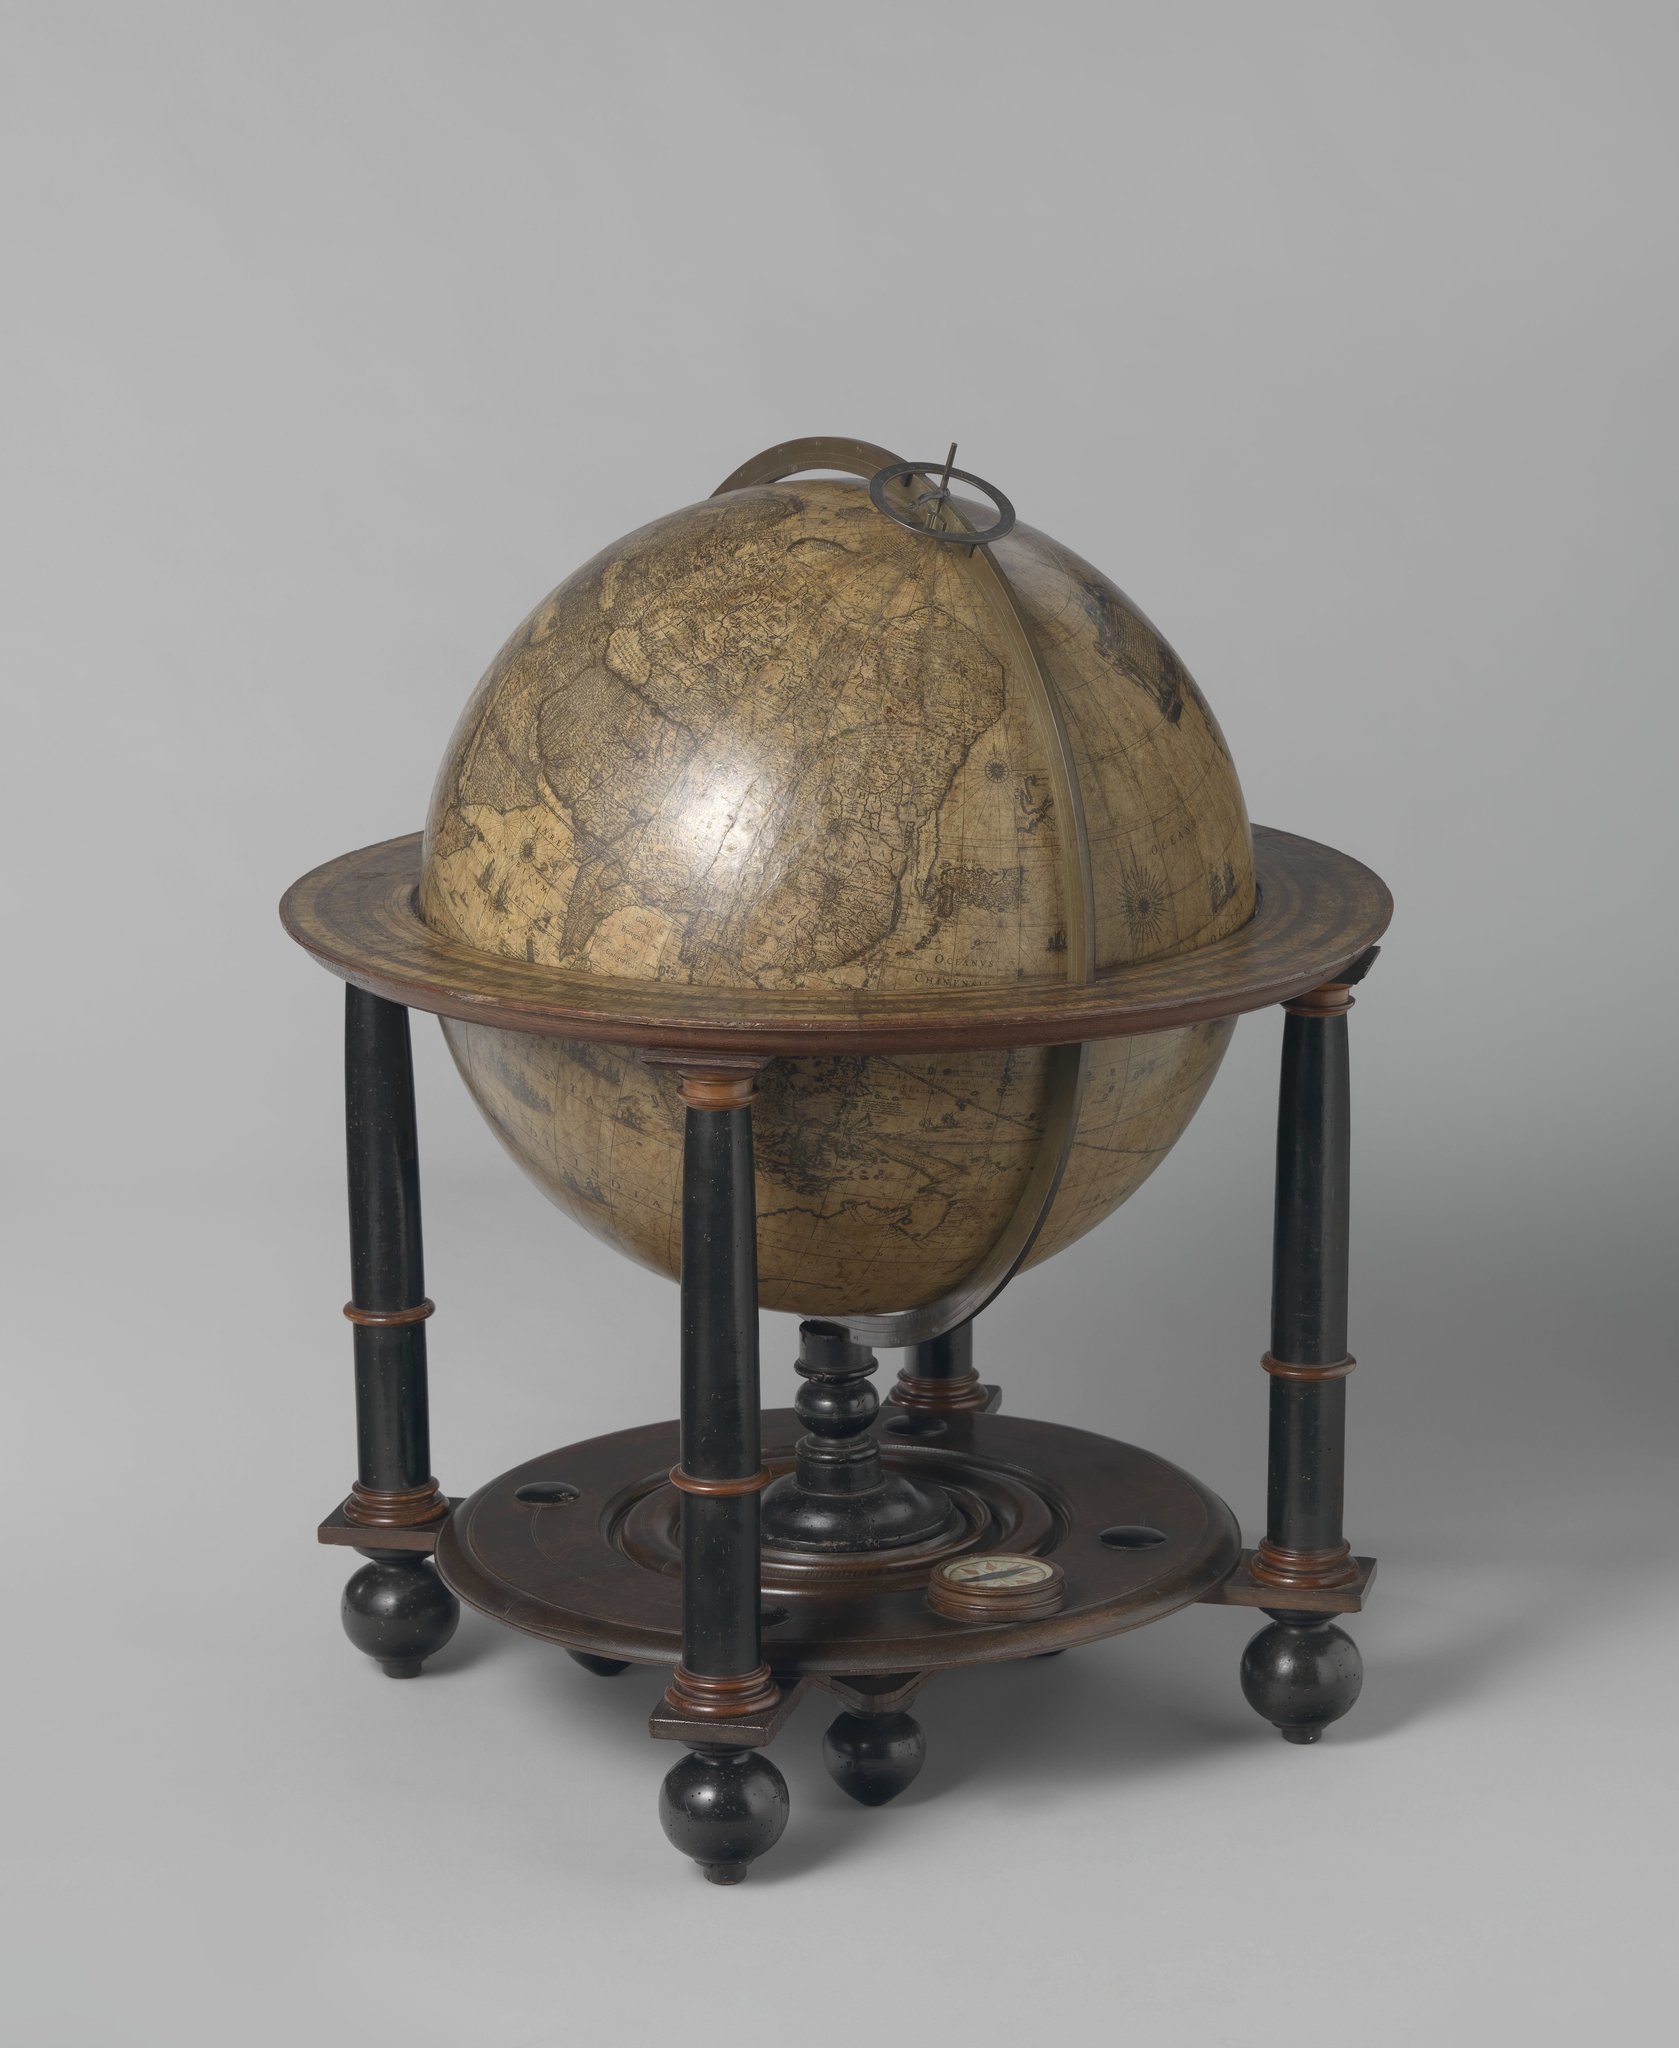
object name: globe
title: Terrestrial globe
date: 1645-1648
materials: copper, gypsum, paper, wood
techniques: engraving, hand coloring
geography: amsterdam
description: Both Blaeus, father and son, were world famous cartographers. The globes that they made were real showpieces. Naturally, they included the latest discoveries of distant lands, and colonies such as ‘Nieu Nederland’ (New York). Yet there were still unexplored territories in the world. Only a small section of the Australian coast had been charted – by Dutchmen, as the name ‘Hollandia Nova’ indicates.